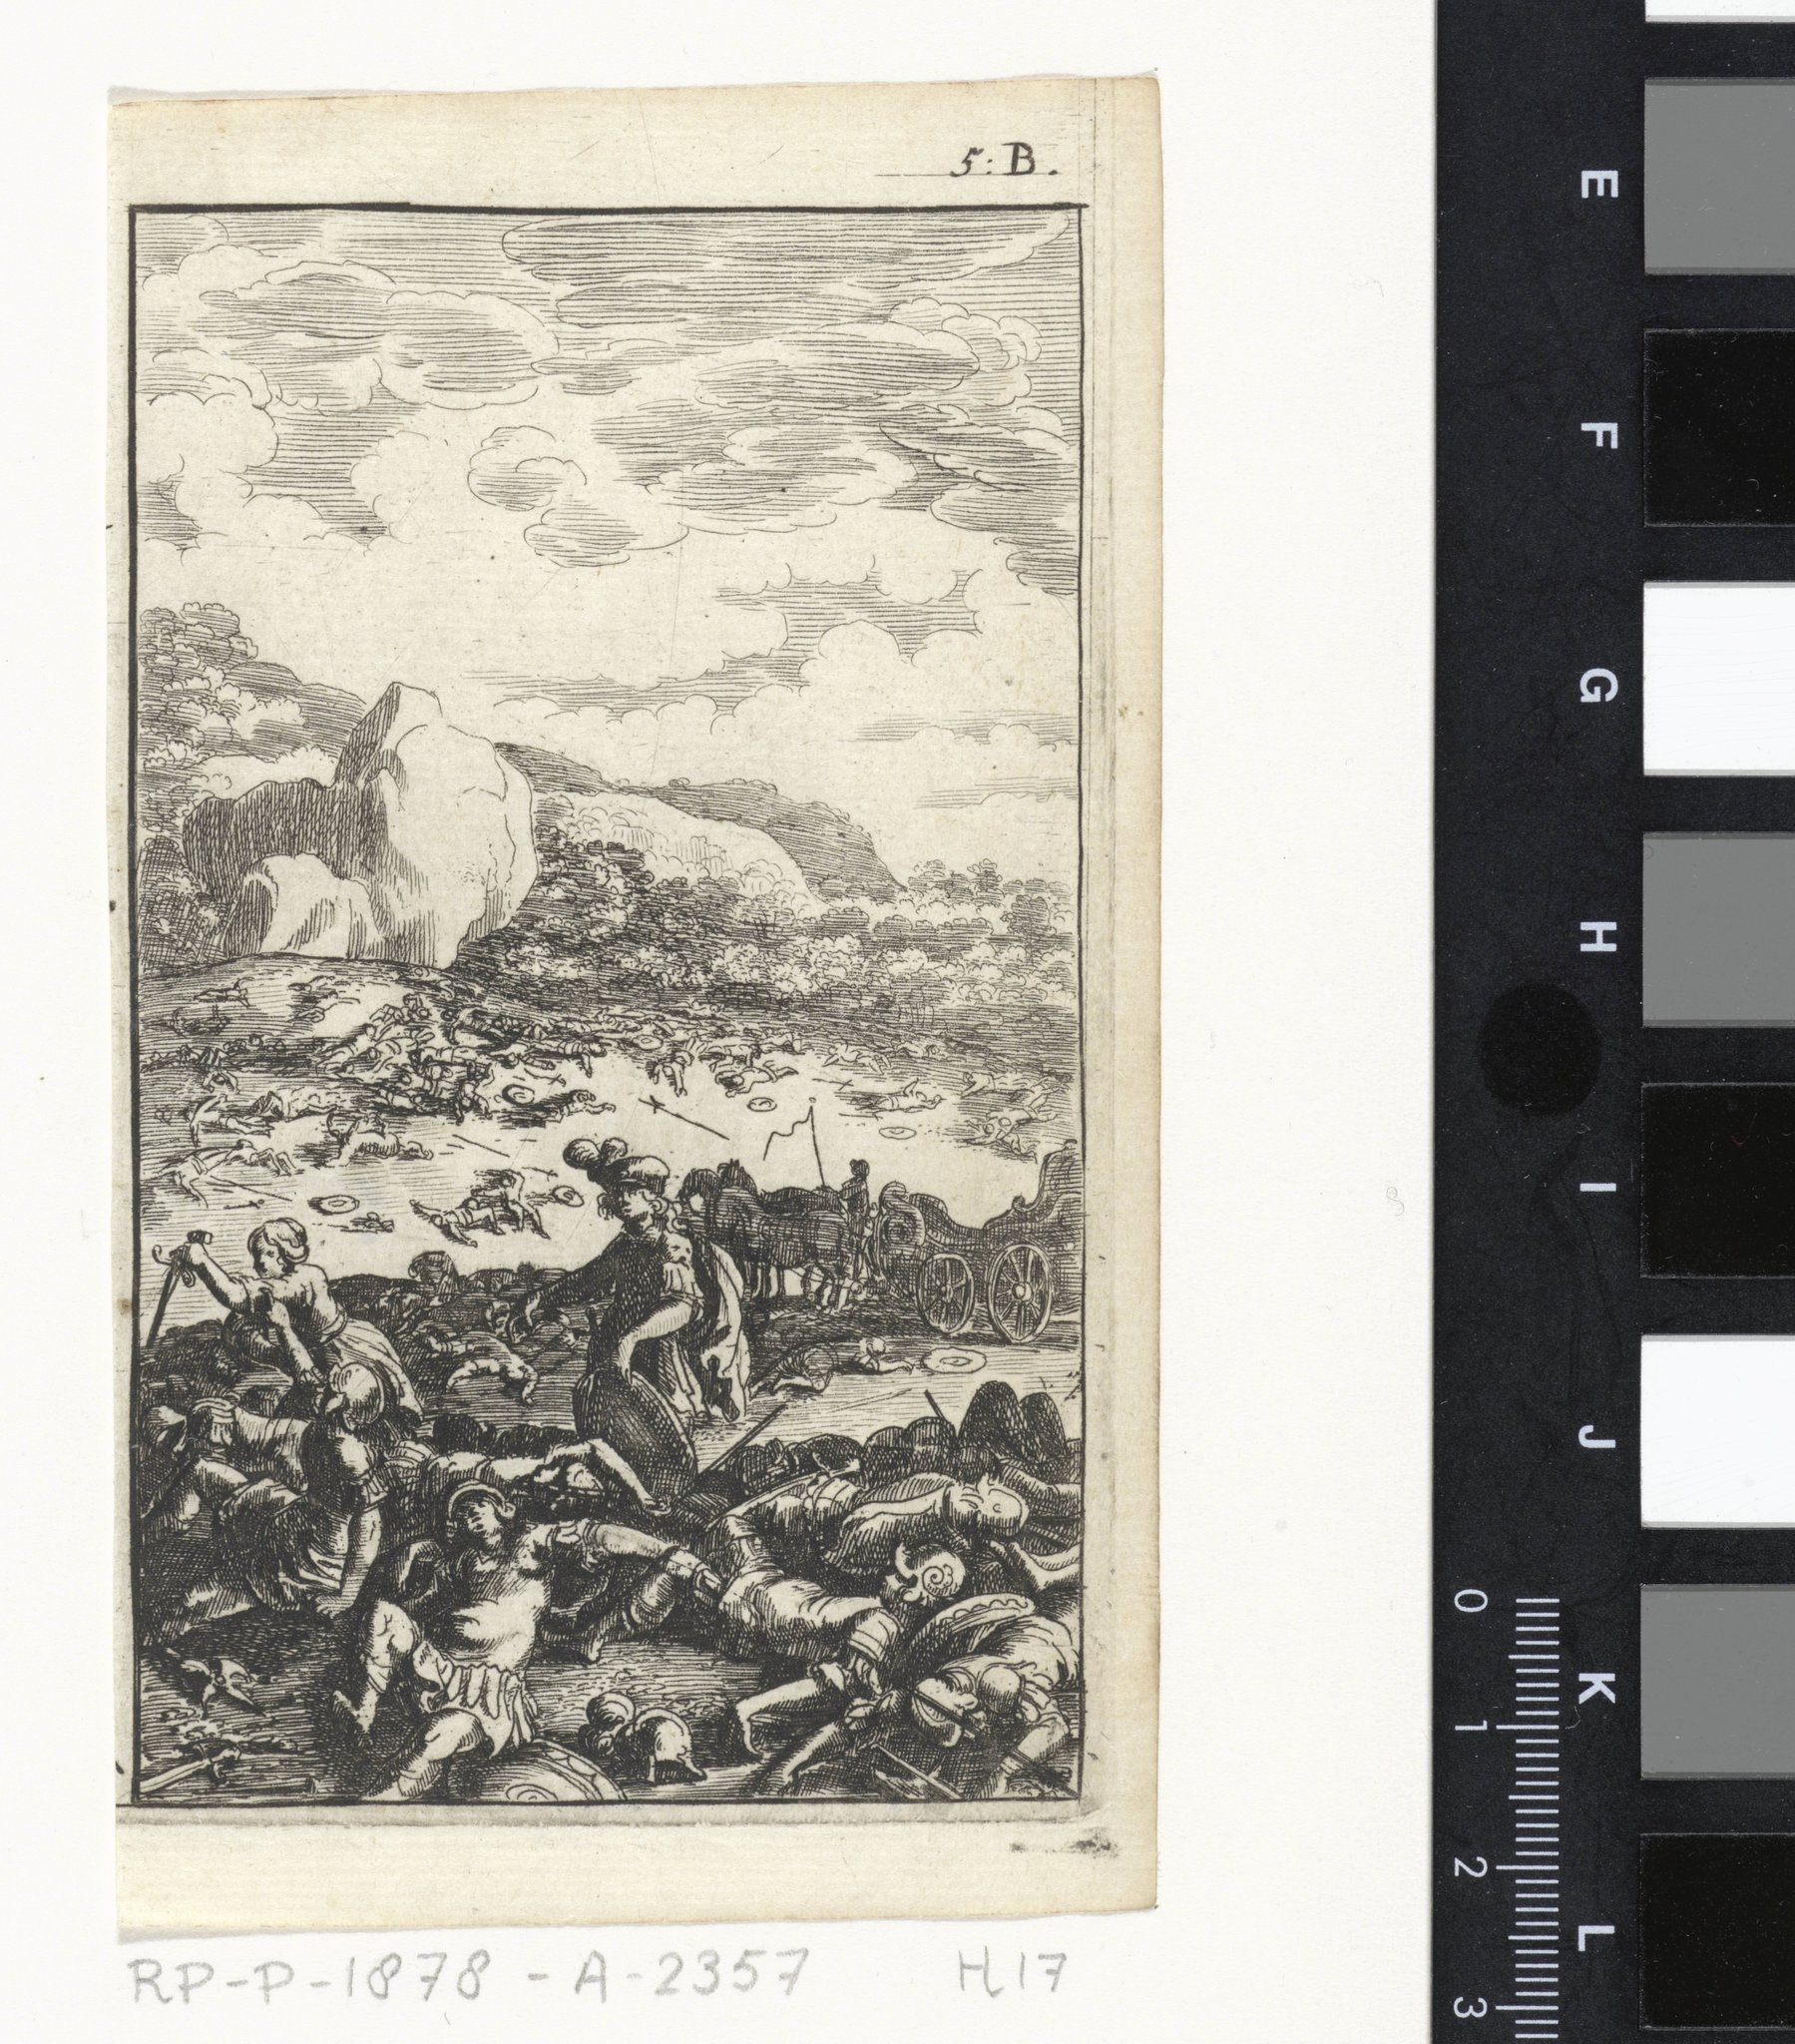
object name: book illustration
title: Slagveld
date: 1666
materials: paper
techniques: etching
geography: netherlands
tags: low hill country, ancient forms of military vehicles: chariot, battle wagon, etc. (+ after the battle), adult woman, battle (+ land forces)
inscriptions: collector's mark: Lugt 2228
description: Een heuvelachtig landschap ligt bezaaid met de lichamen van gedode soldaten. Links vooraan doodt een vrouw, Cleopatra Selene II(?), de laatste overlevenden. Achter haar staat een man, koning Juba II(?), met een schild. Rechts een strijdwagen met twee paarden. Rechtsboven: 5: B.